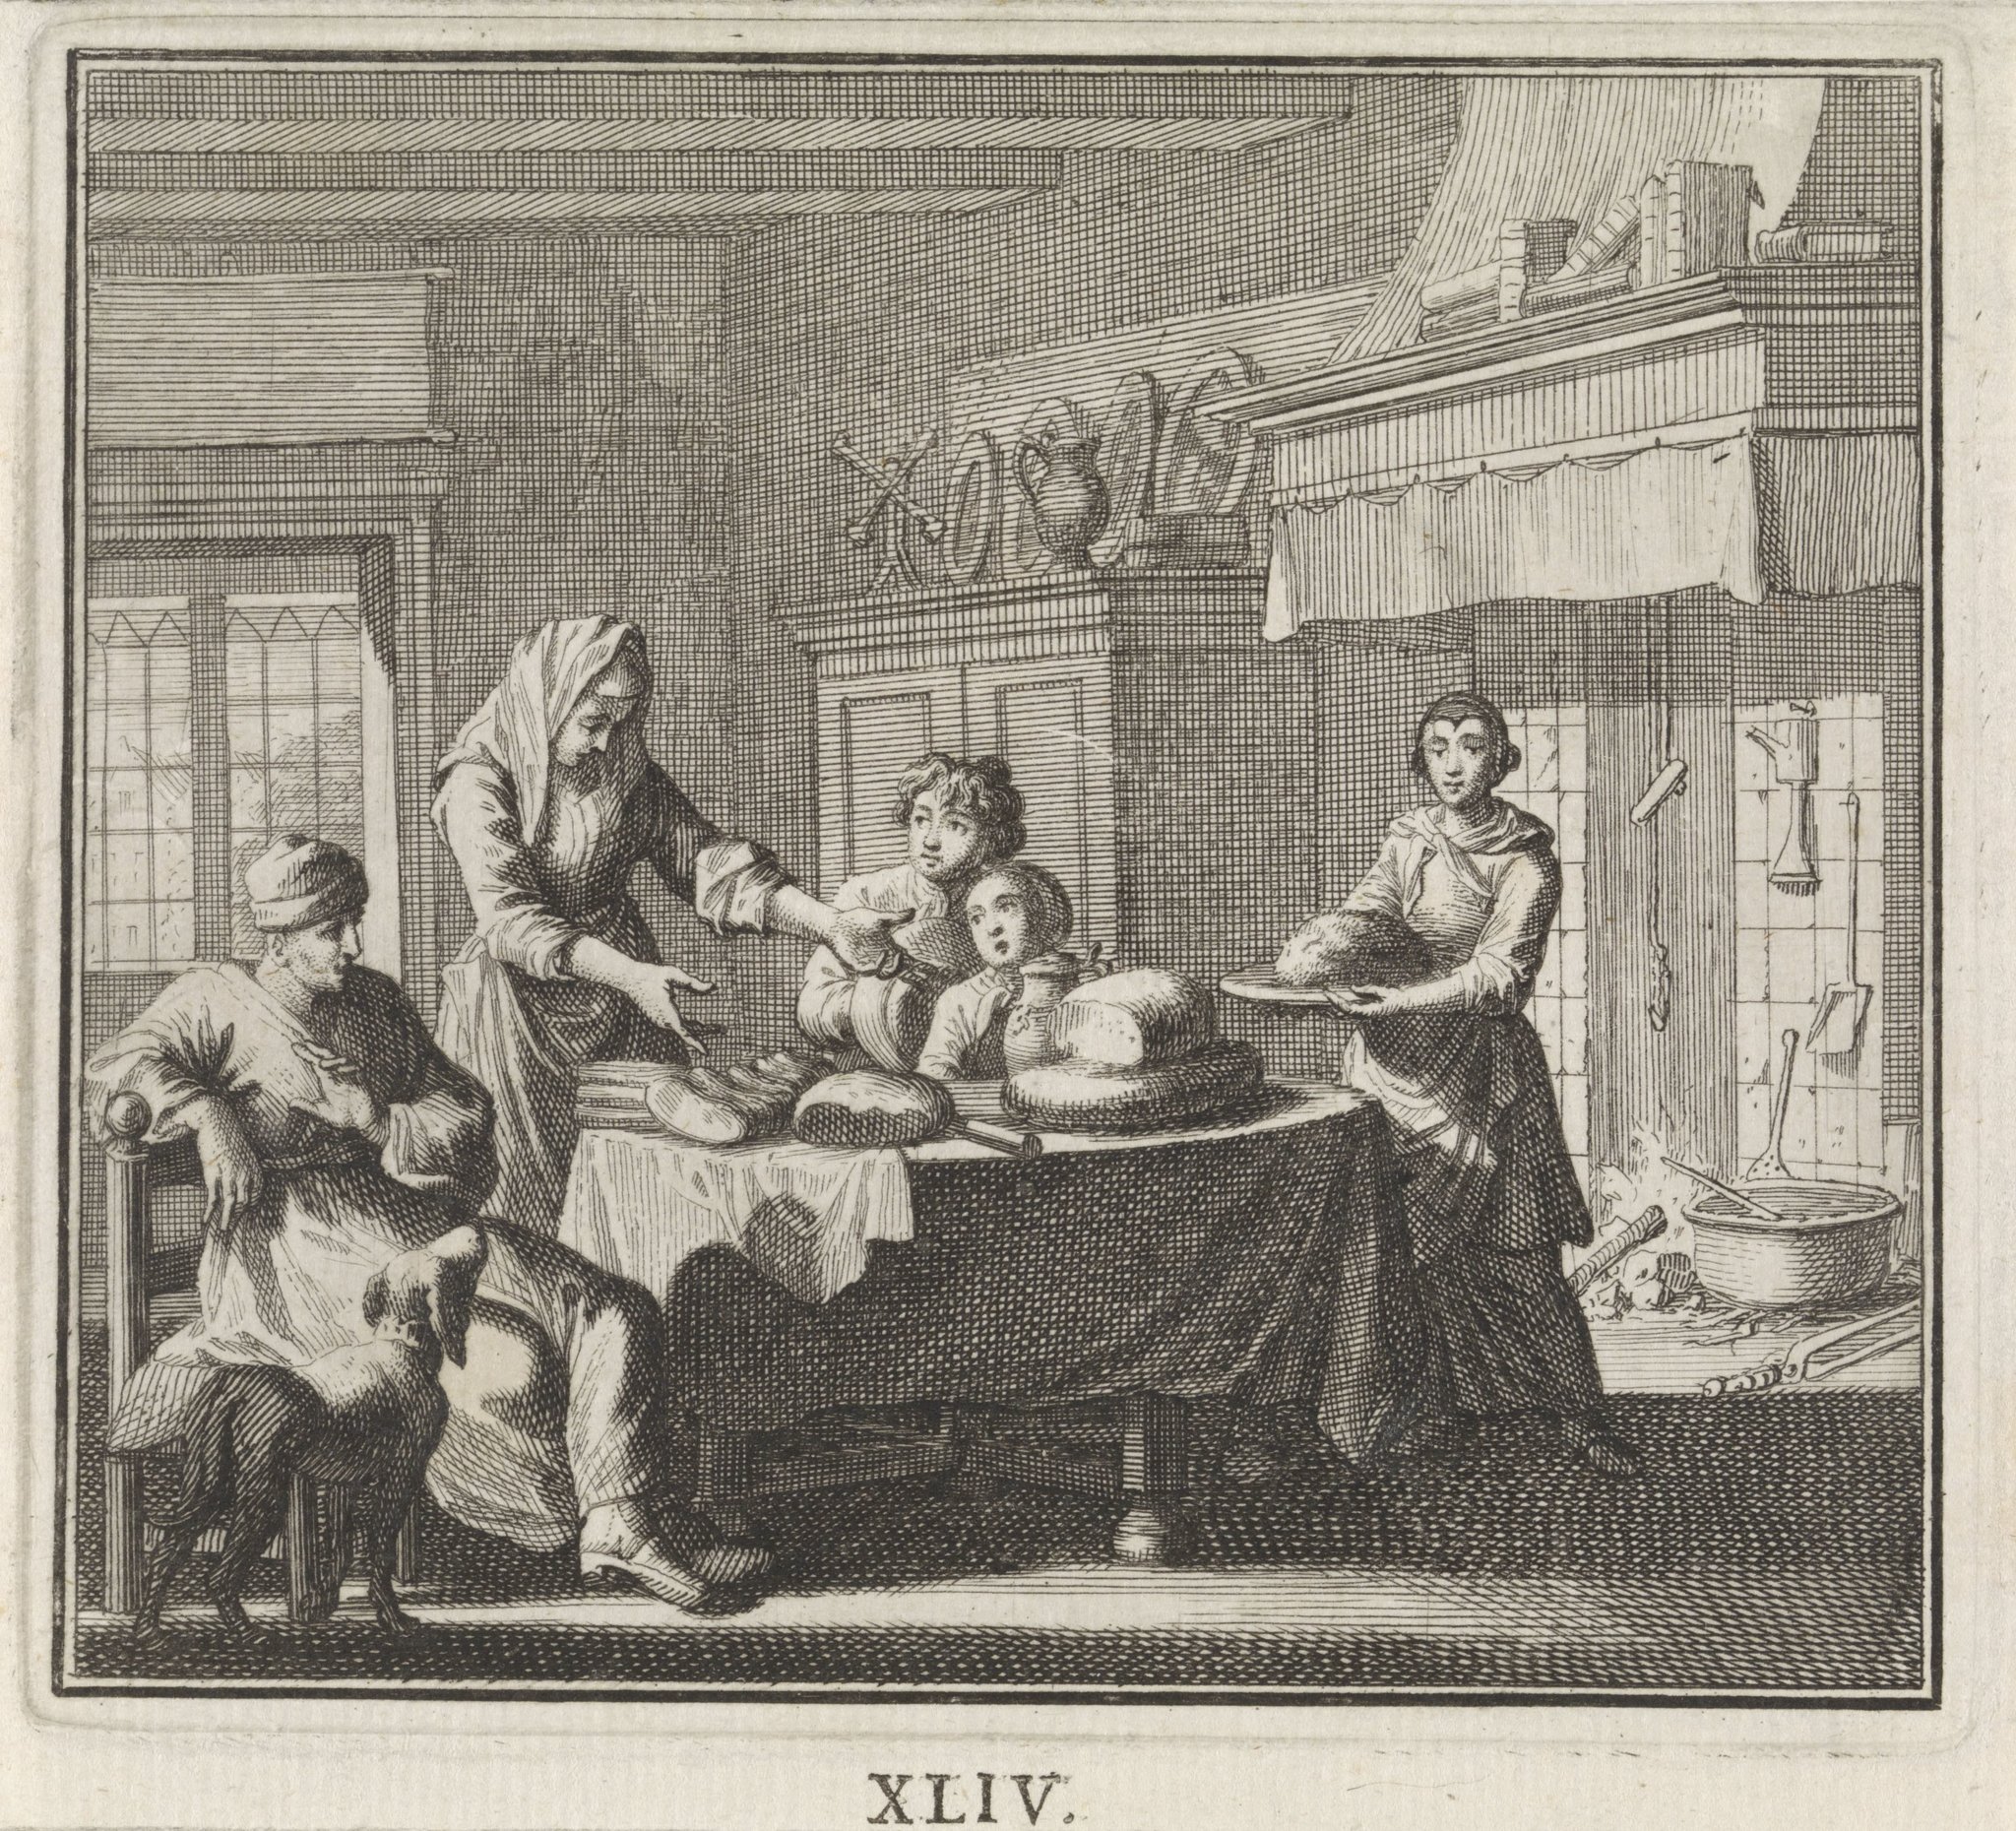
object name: print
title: Familie rond een tafel voor het middagmaal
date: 1695-1705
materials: paper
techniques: etching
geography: nuremberg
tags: laying the table, interior of the house, midday meal, lunch, family life at home, abstract ideas and concepts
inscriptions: collector's mark: Lugt 2228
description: Boekillustratie voor Weigel, Christoph. Ethica Naturalis seu Documenta Moralia e Variis rerum Naturalium proprietatibus Virtutum Vitiorumq symbolicis imaginibus collecta. Neurenberg: Christoph Weigel: c. 1700.